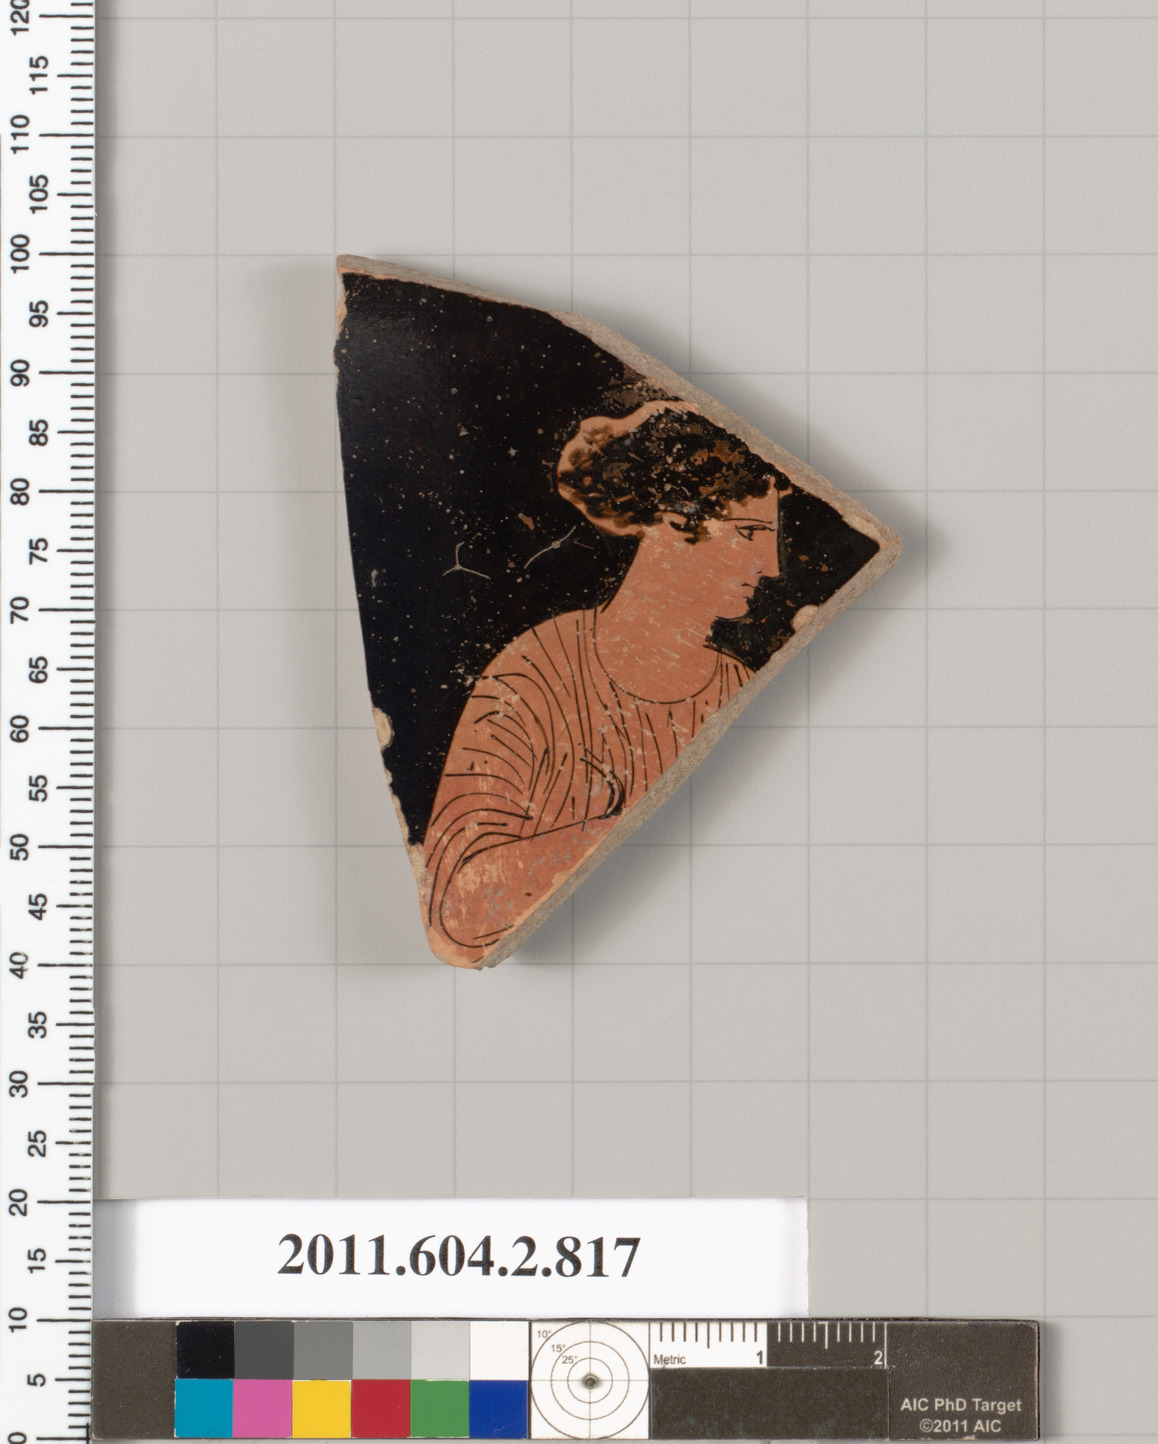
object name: bell krater fragment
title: Terracotta fragment of a bell-krater (bowl for mixing wine and water)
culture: greek, attic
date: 460-440 BCE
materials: terracotta